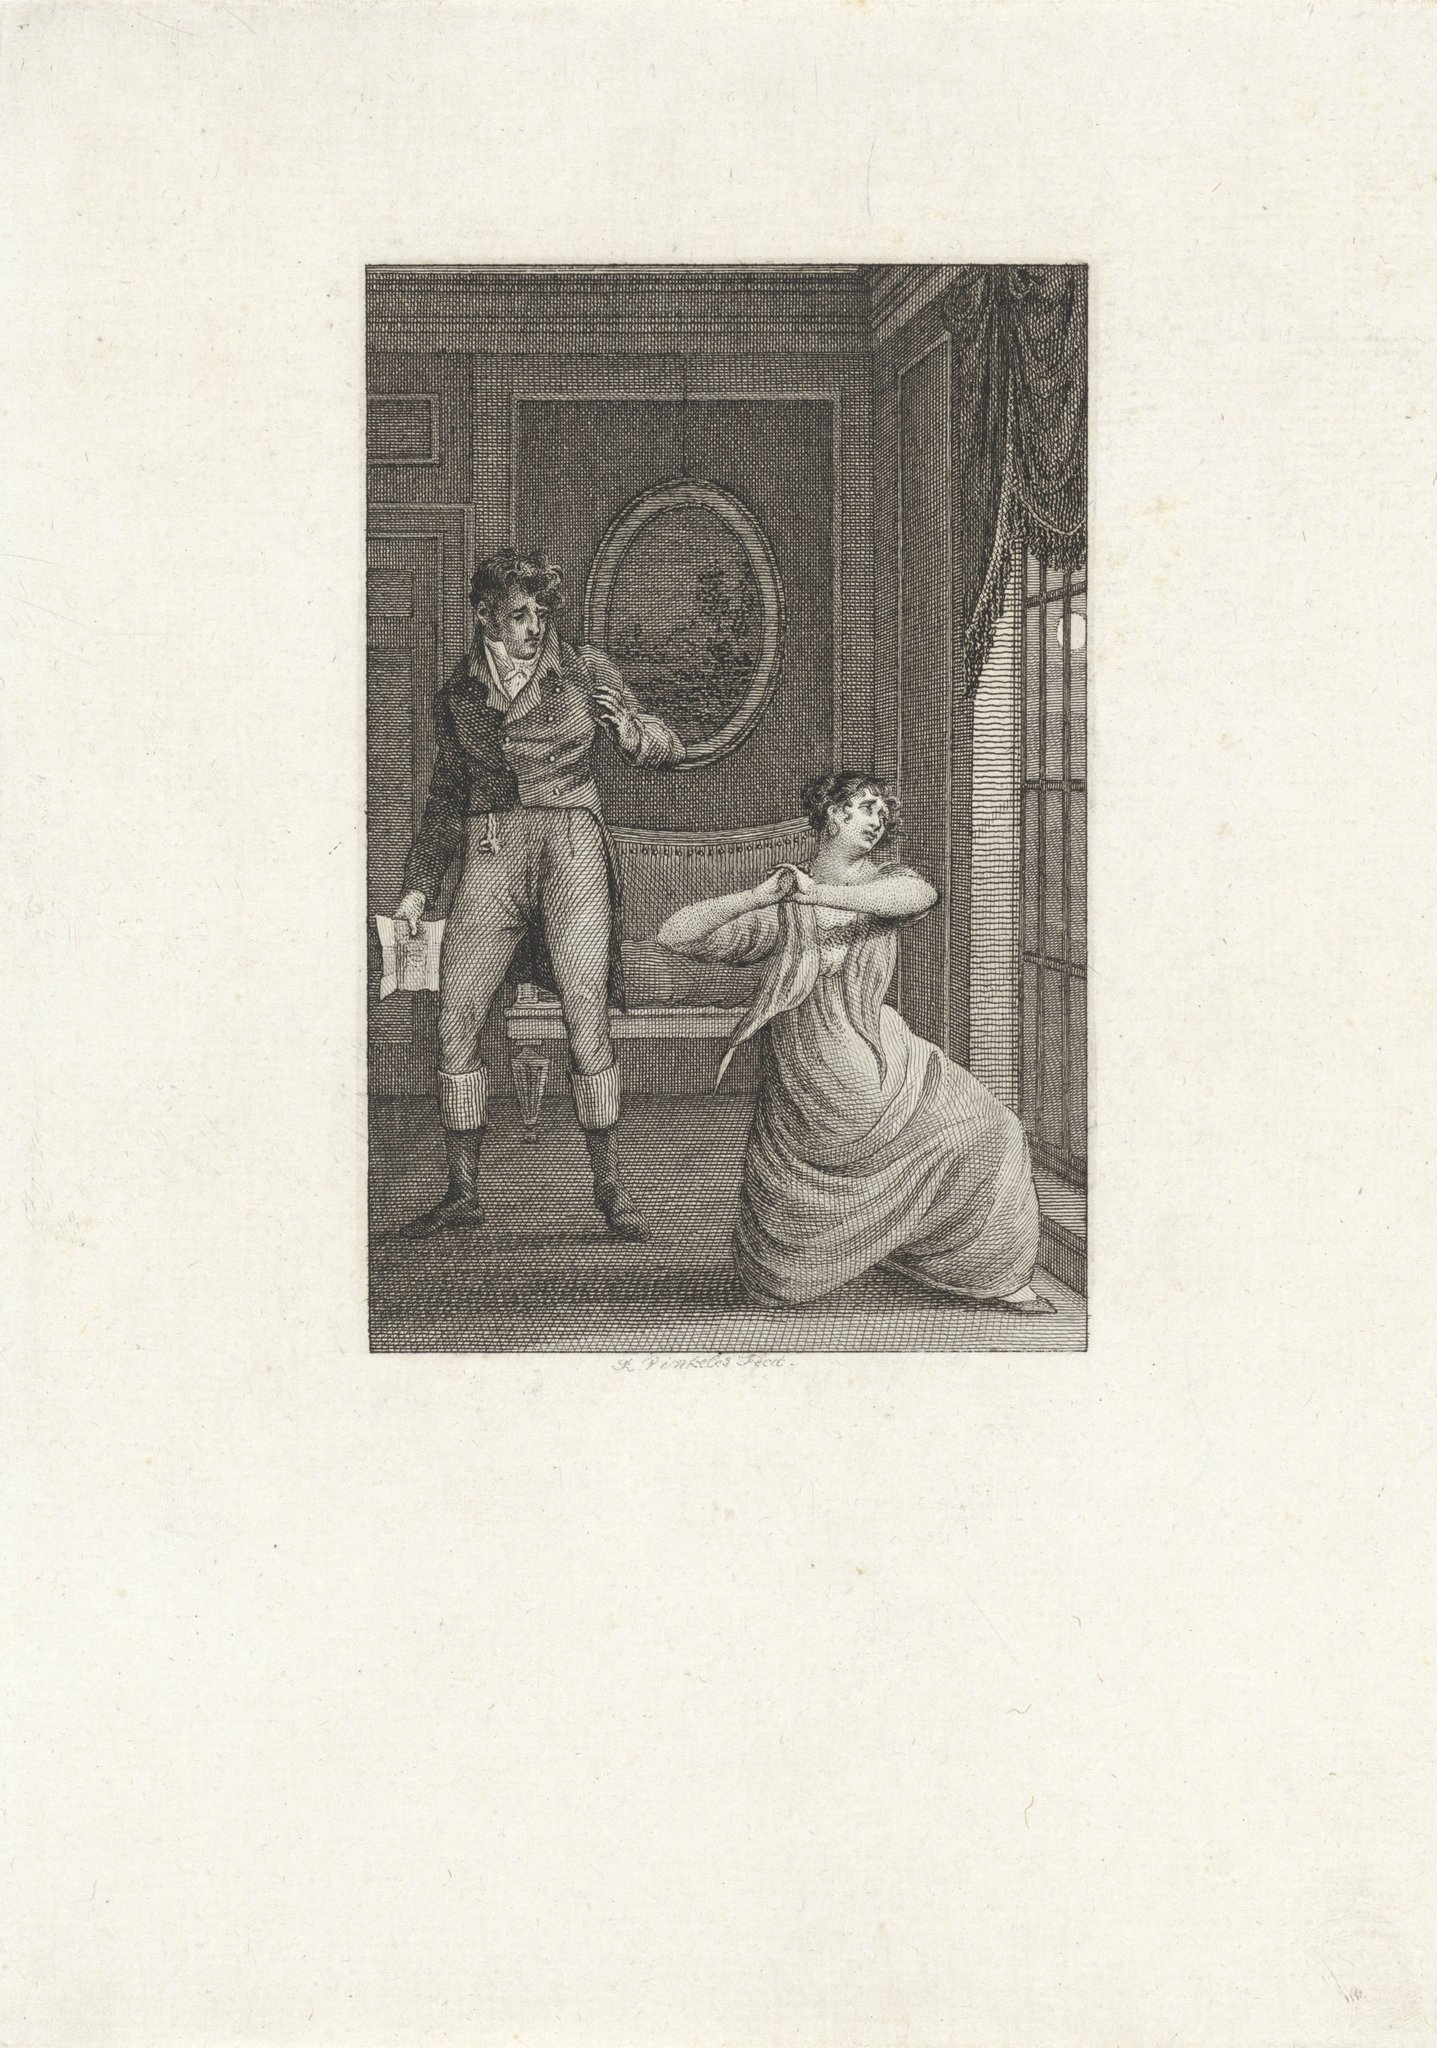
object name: print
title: Man met een brief en een knielende vrouw voor het raam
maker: reinier vinkeles (i)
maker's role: draughtsman, print maker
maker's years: 1741-1816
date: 1751-1816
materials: paper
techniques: engraving, etching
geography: amsterdam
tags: full moon, kneeling figure, letter, envelope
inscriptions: collector's mark: Lugt 2228